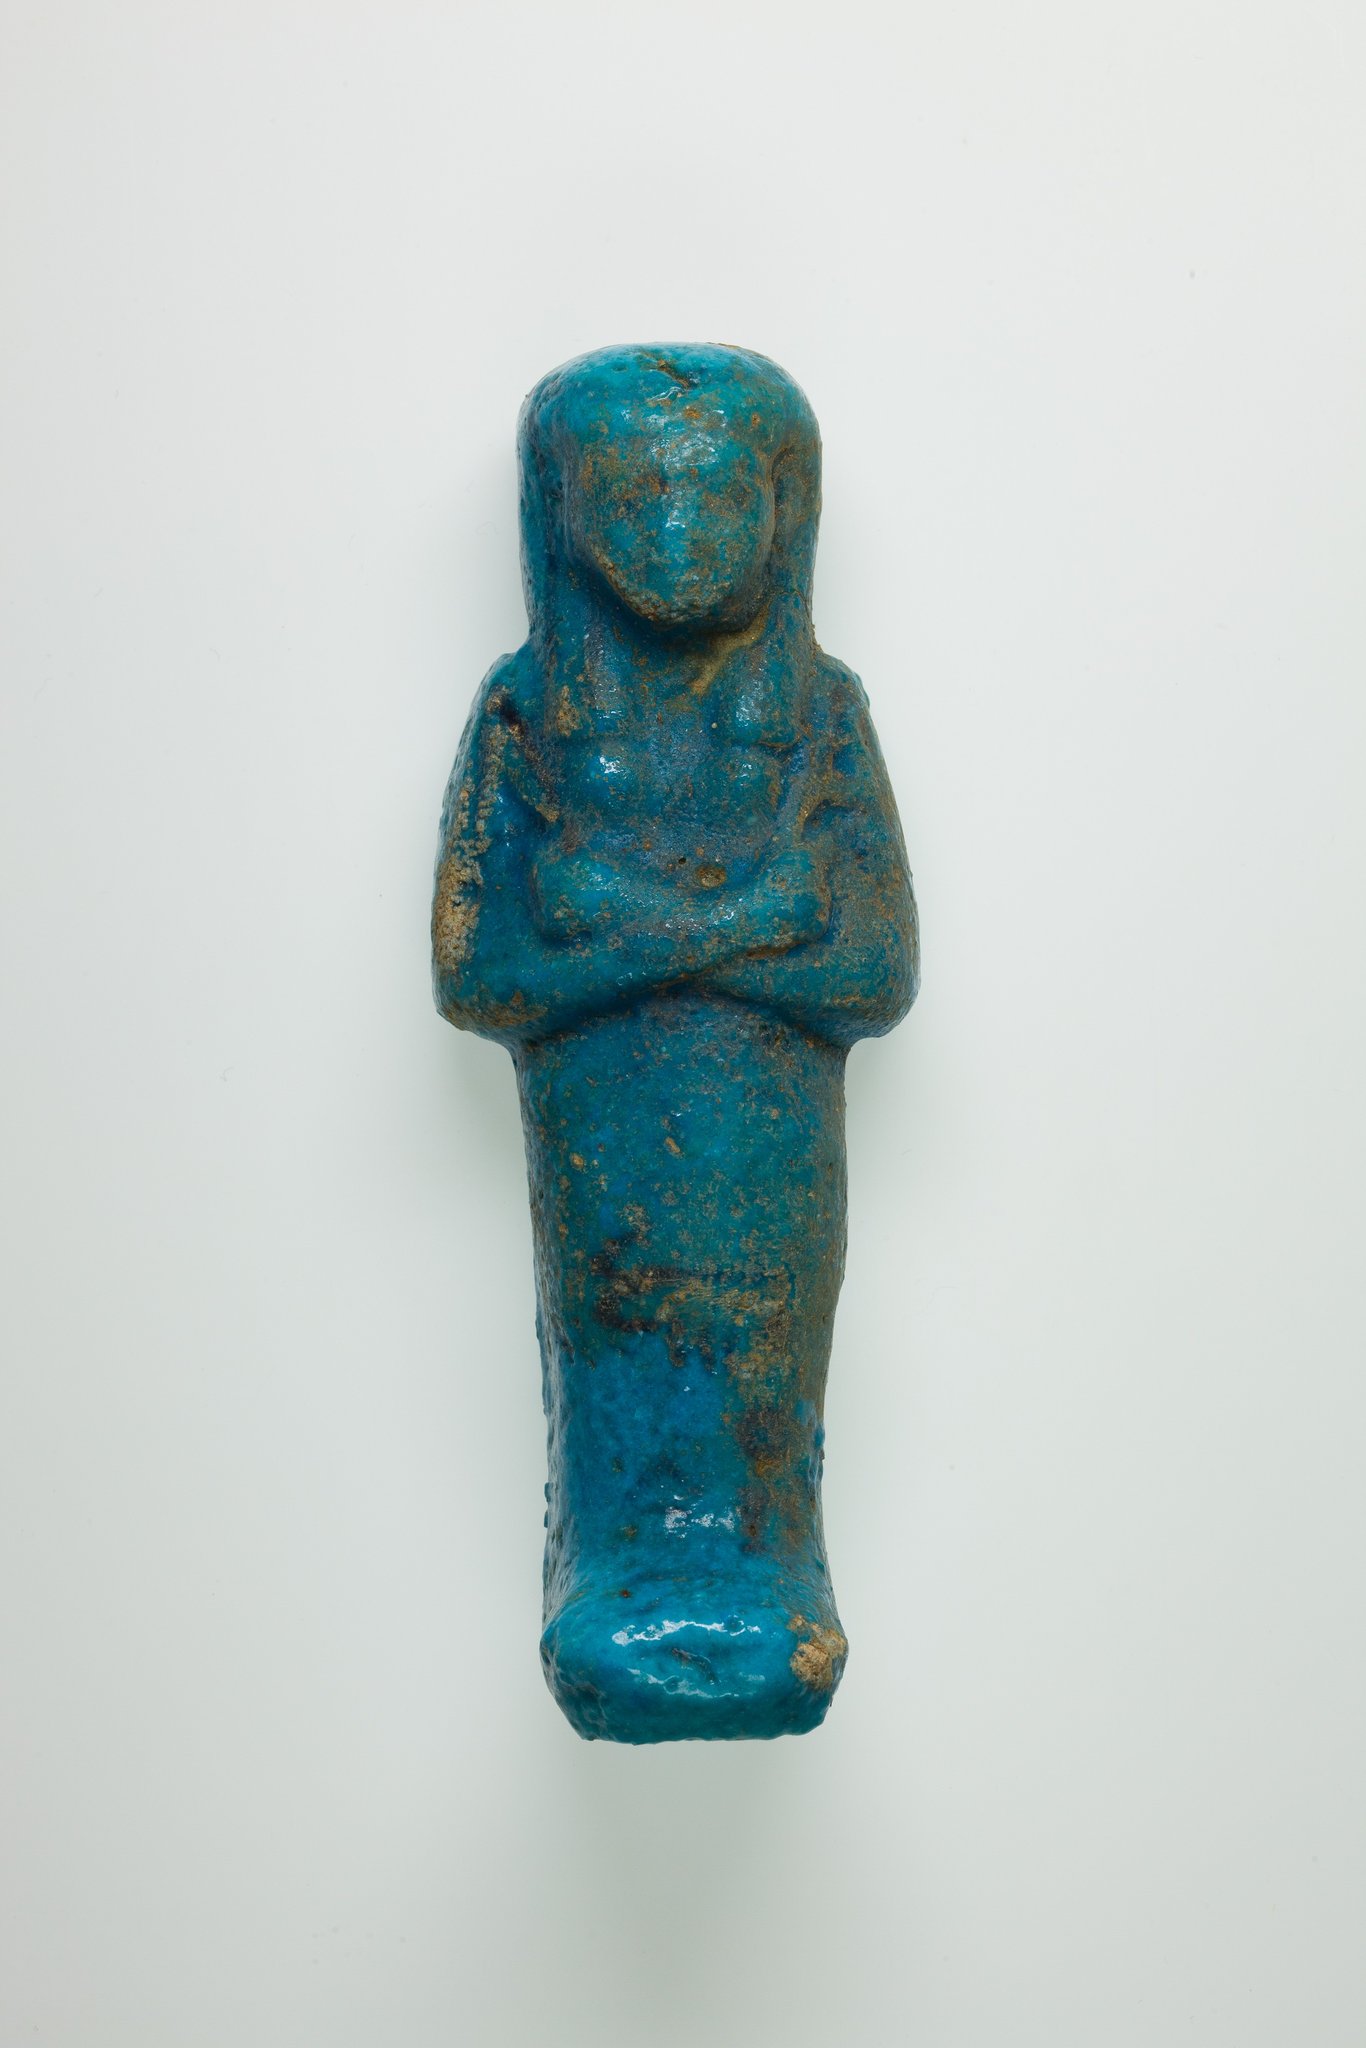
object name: shabti, henettawy c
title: Worker Shabti of Henettawy (C), Daughter of Isetemkheb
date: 990-970 BCE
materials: faience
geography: egypt